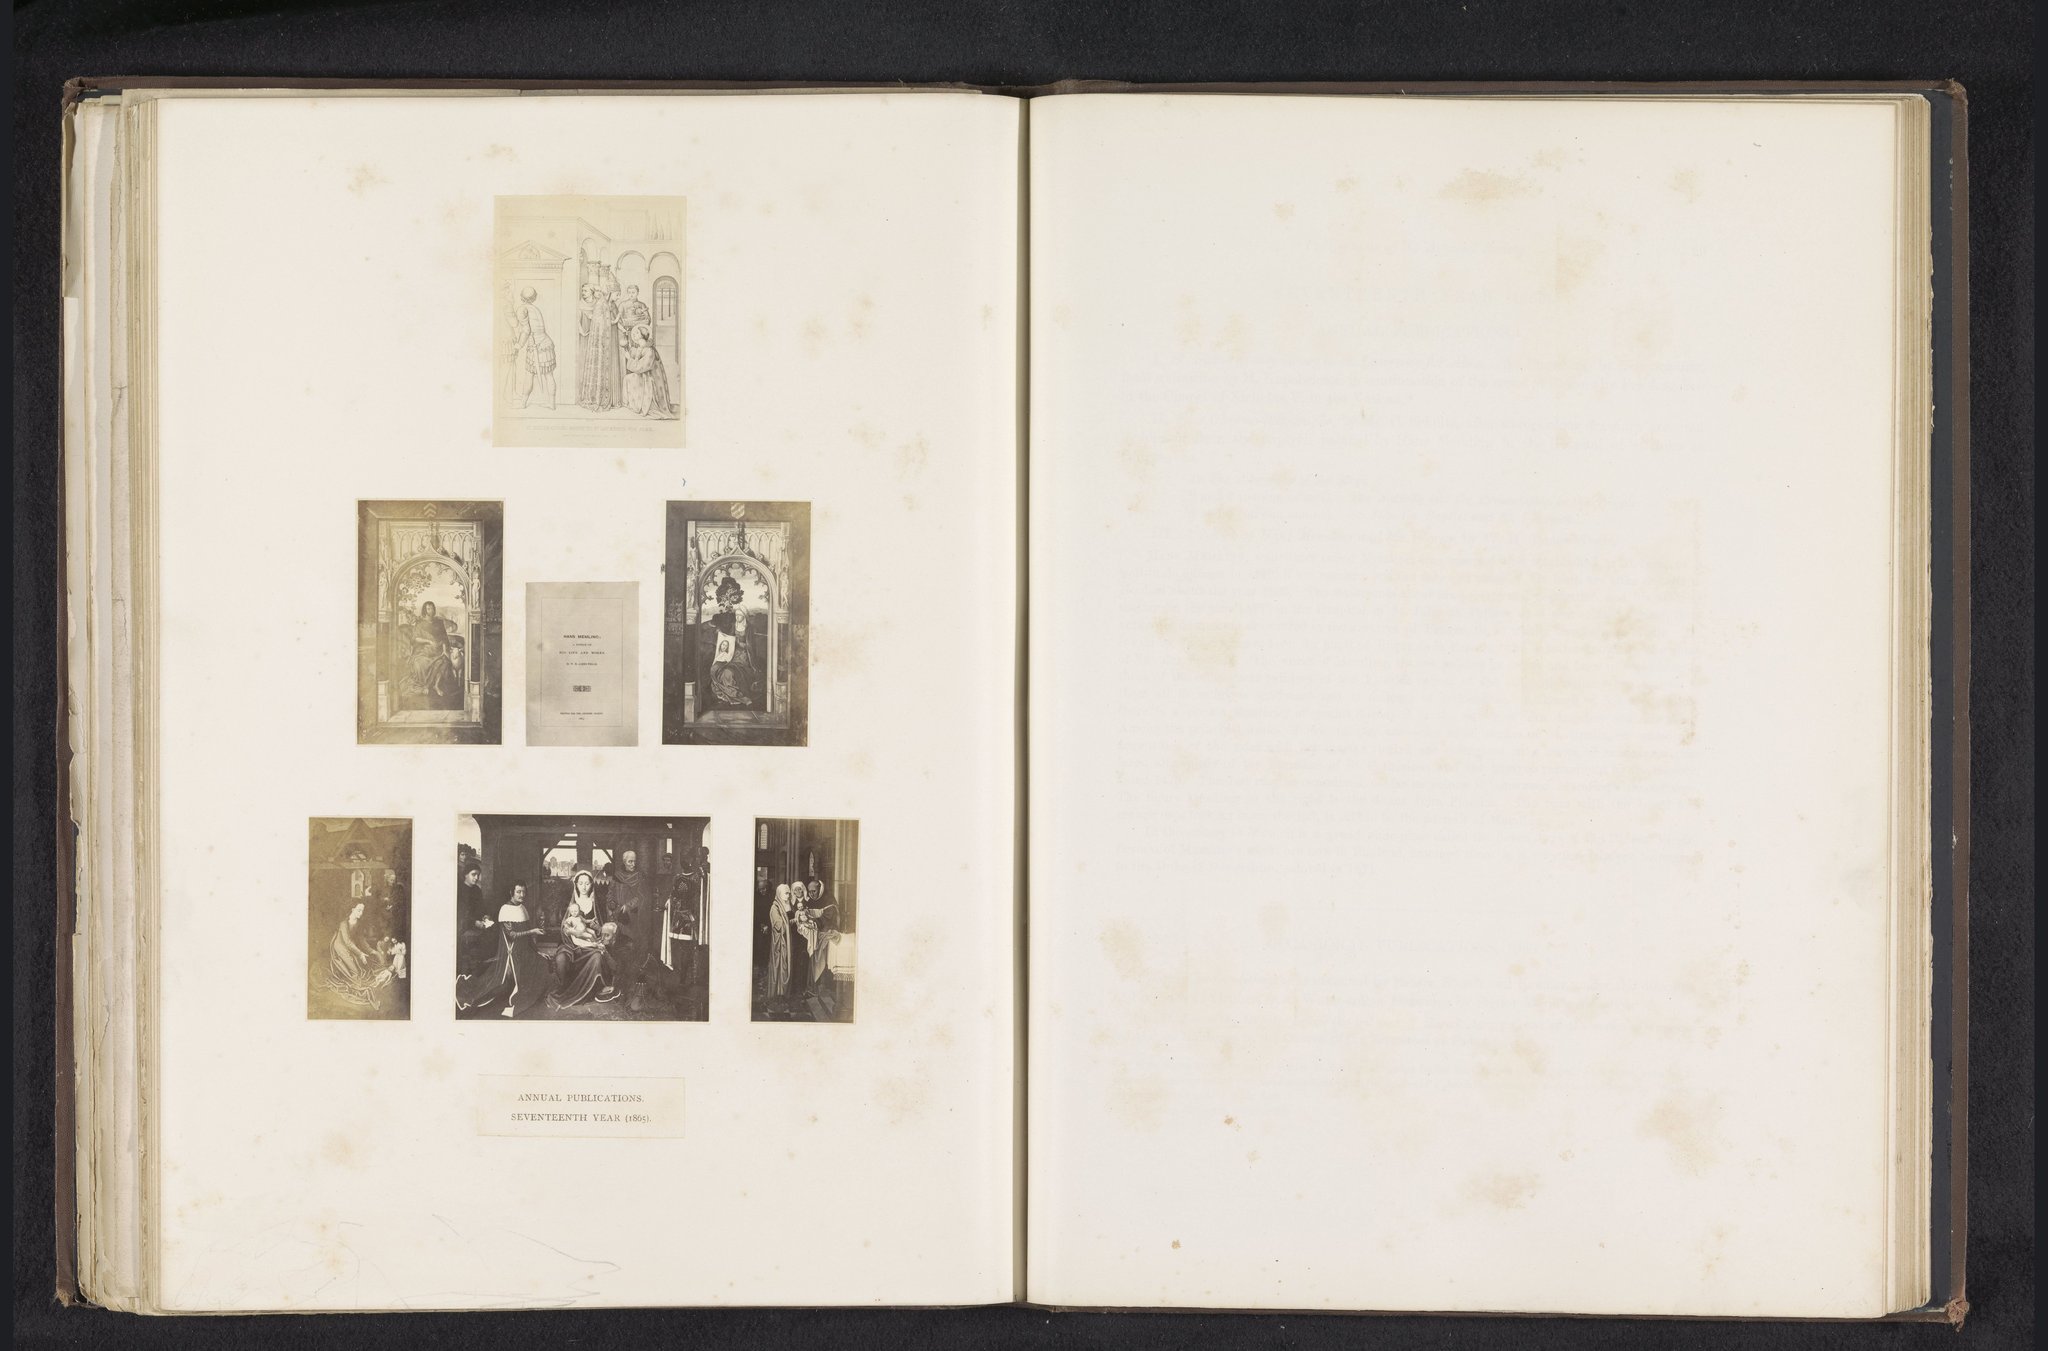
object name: reproduction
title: Zeven fotoreproducties van een publicatie door de Arundel Society met schilderijen van Hans Memling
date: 1859-1869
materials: photographic support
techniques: albumen print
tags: book, painting (including book-illumination, miniature-painting)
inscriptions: inscription: ‘annual publications, seventeenth year (1865).’